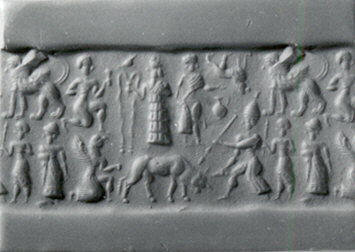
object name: cylinder seal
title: Cylinder seal and modern impression: man spearing bull; griffin demon; deities above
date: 1820-1730 BCE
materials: mineral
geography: syria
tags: men,griffins,bulls